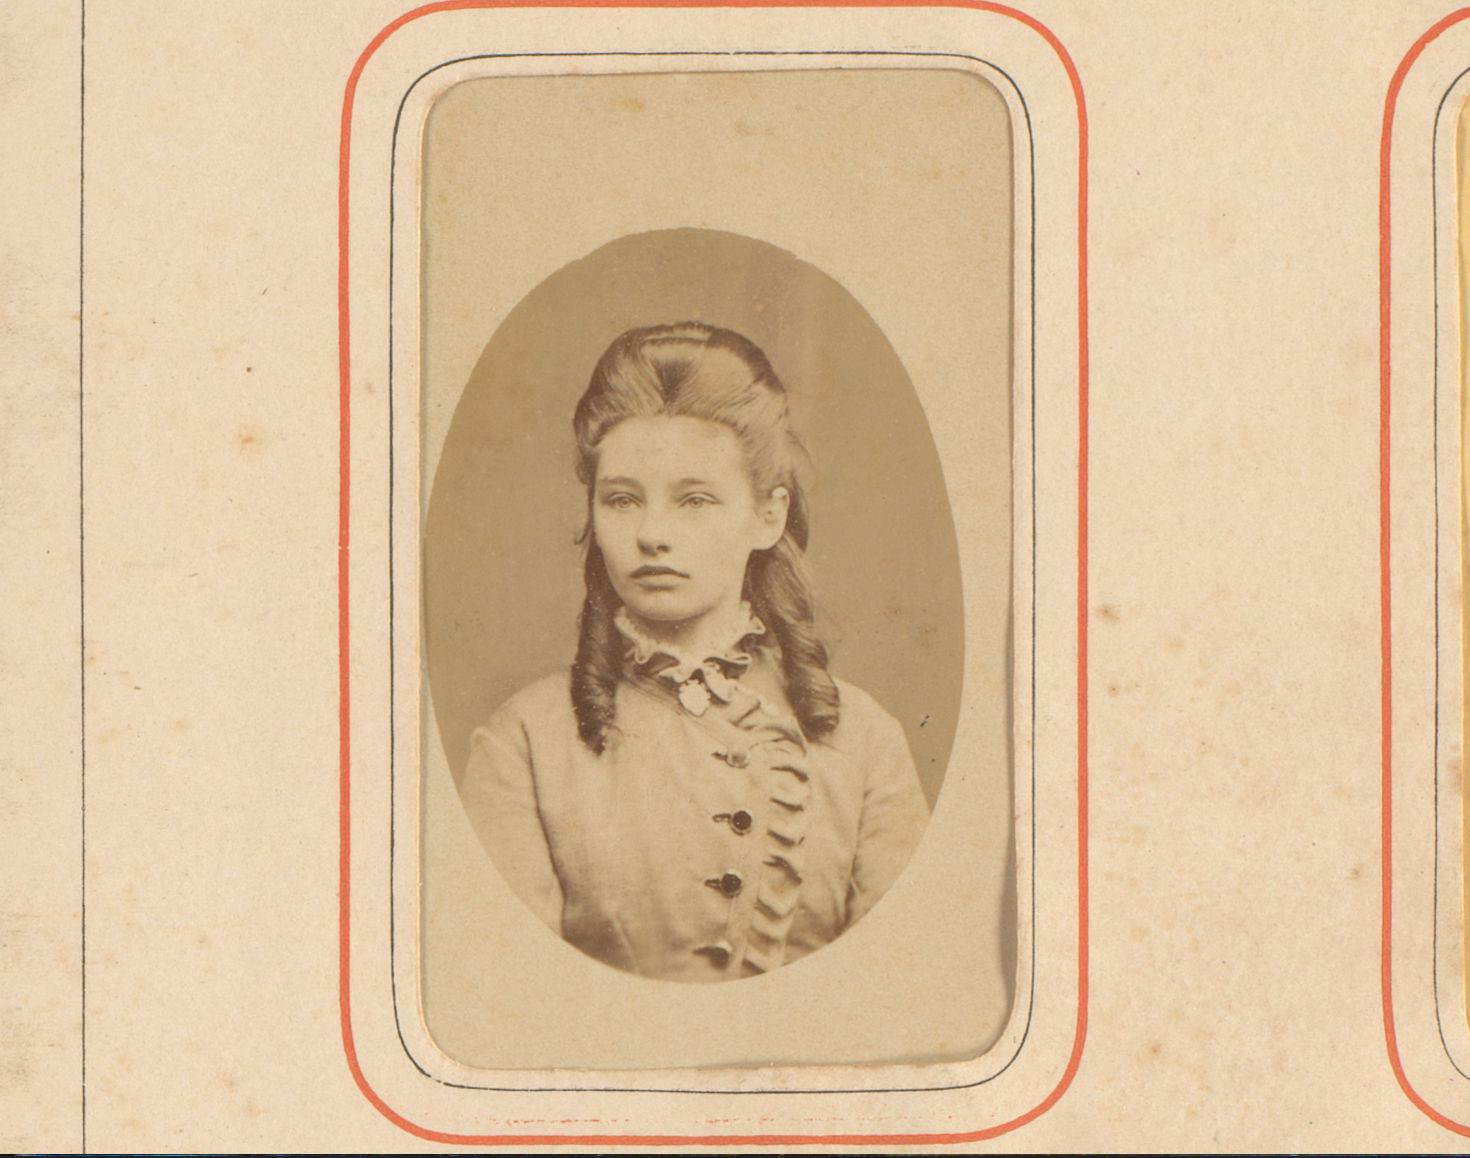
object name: carte de visite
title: Portret van een onbekend meisje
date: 1874-1883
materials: cardboard, paper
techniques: albumen print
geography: alkmaar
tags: anonymous historical person portrayed - bb - woman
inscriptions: address: ‘Verdonken Oord/ Wijk D. No 34./ ALKMAAR.’